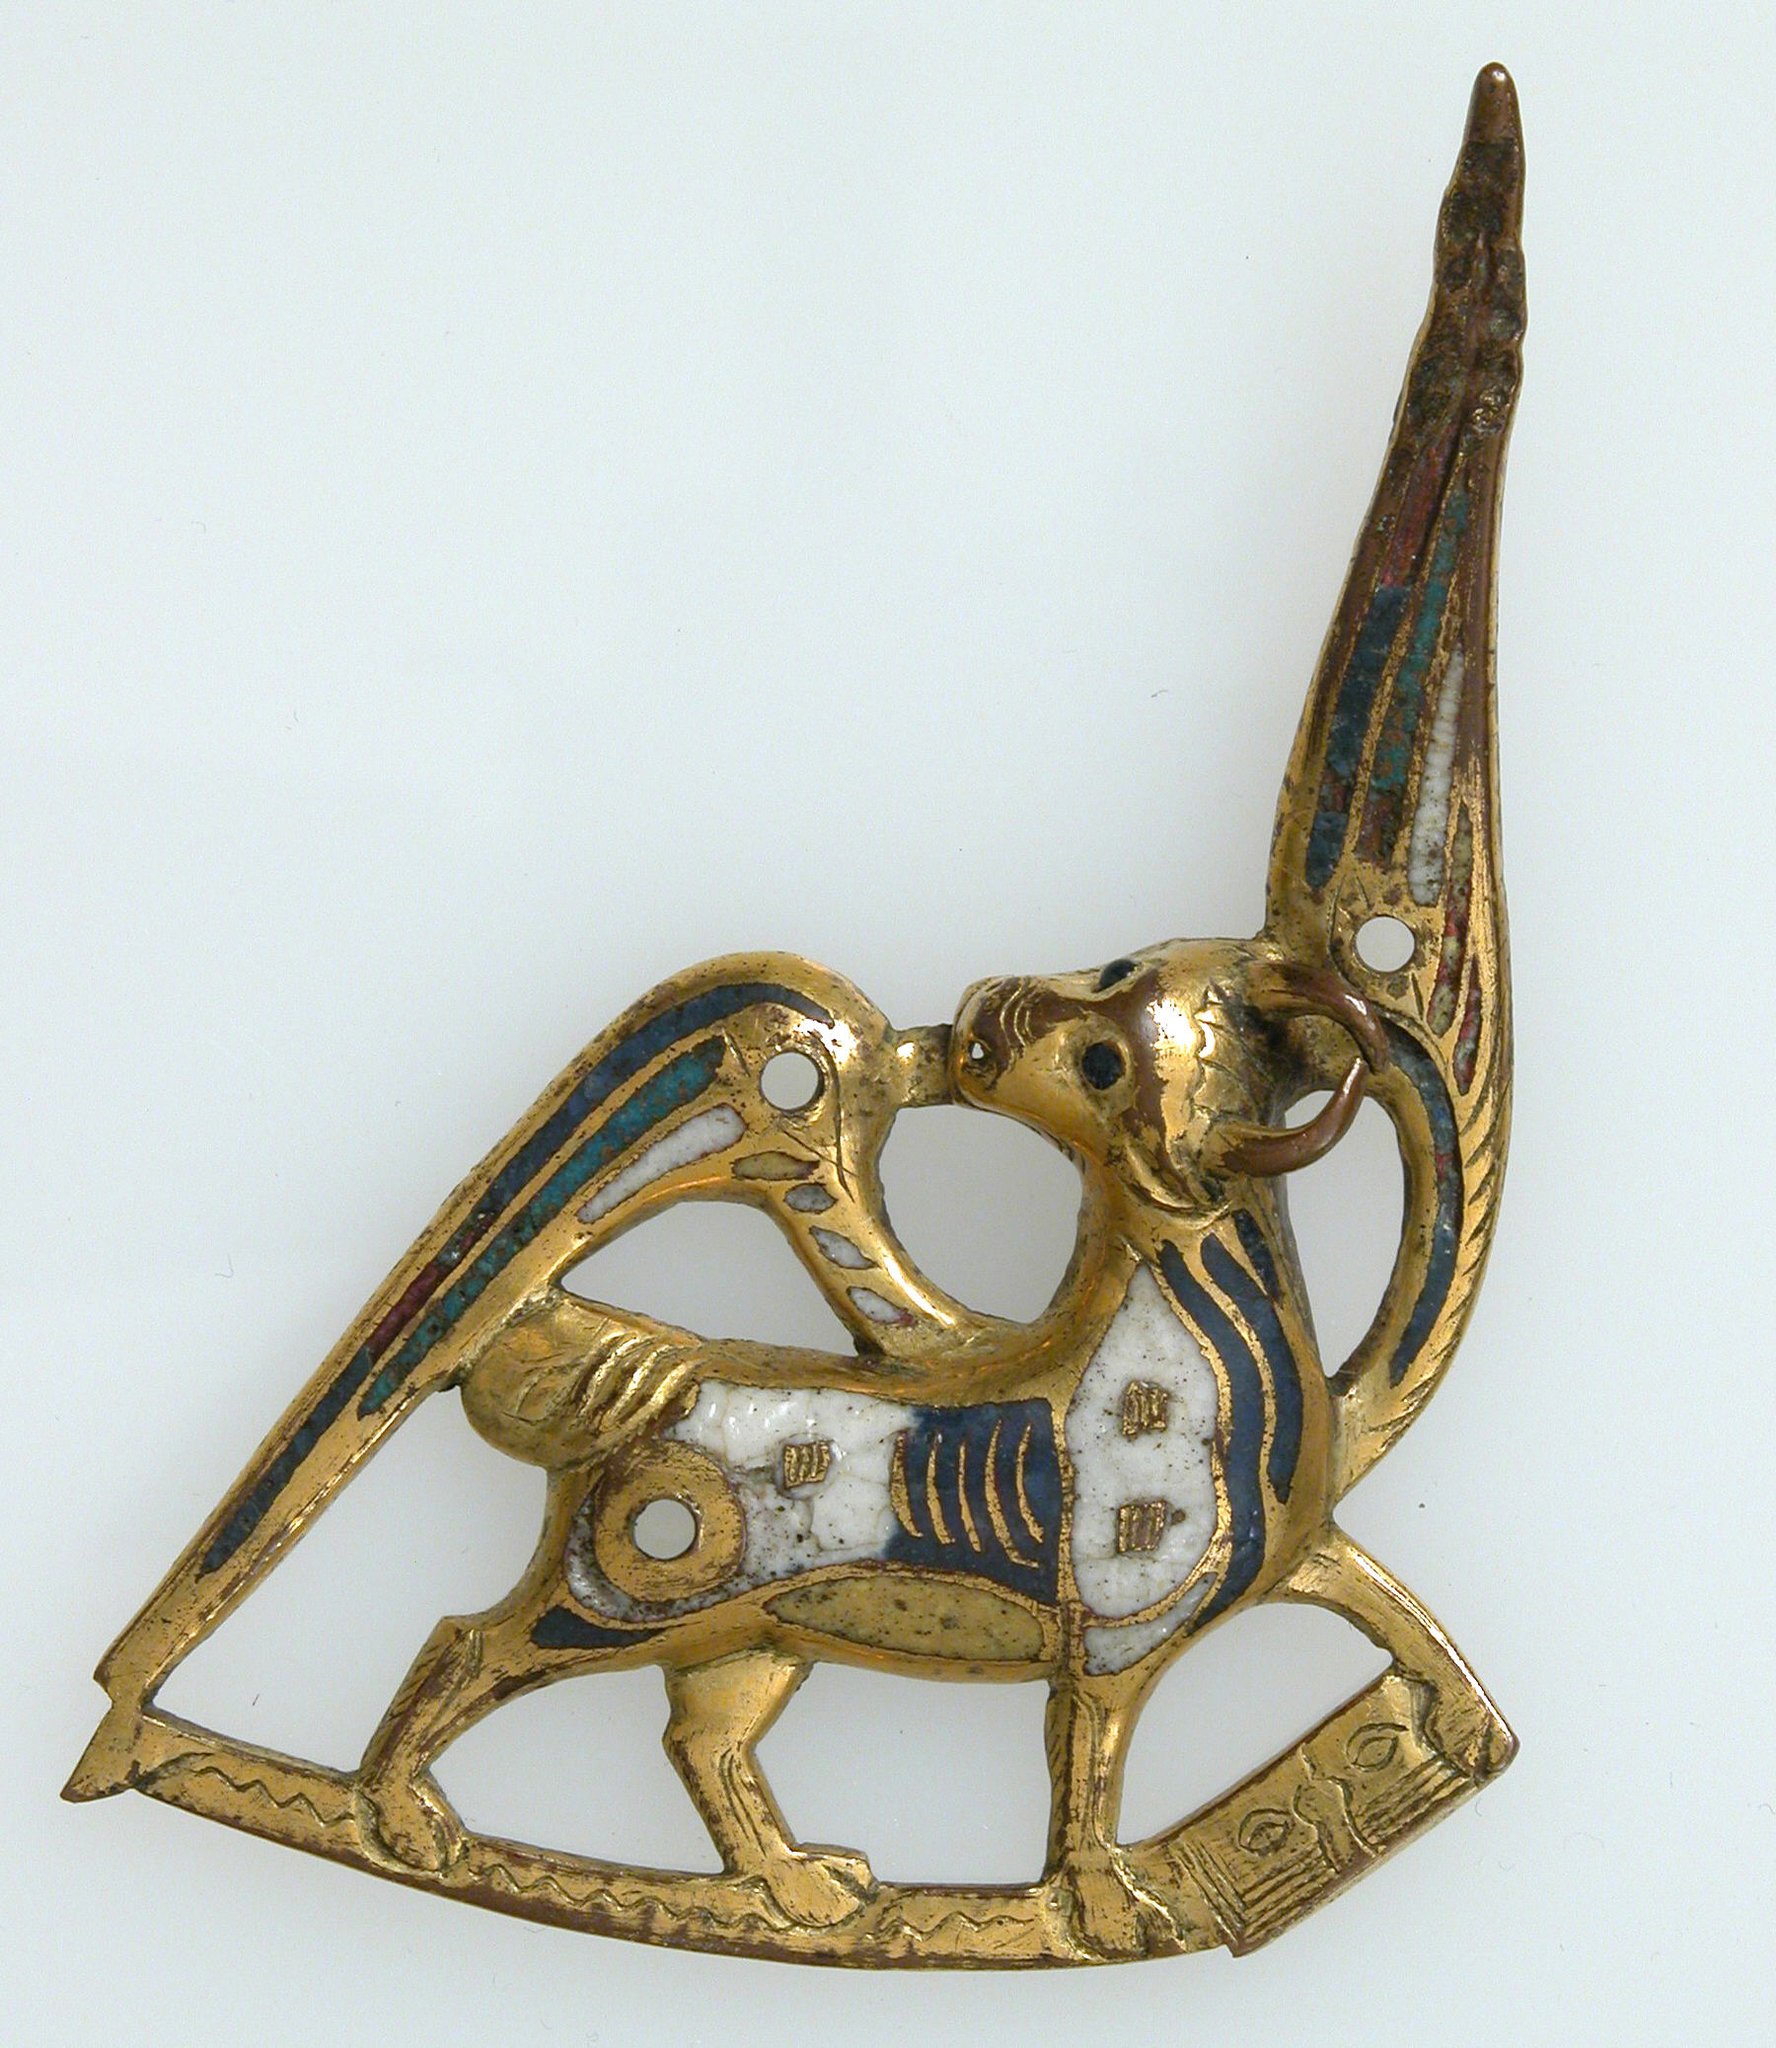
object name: appliqué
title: The Ox of Saint Luke (one of two appliqués from a book cover)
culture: french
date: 1200-1225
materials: copper, enamel, gilt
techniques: enamel, chasing, engraving, repoussé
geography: france